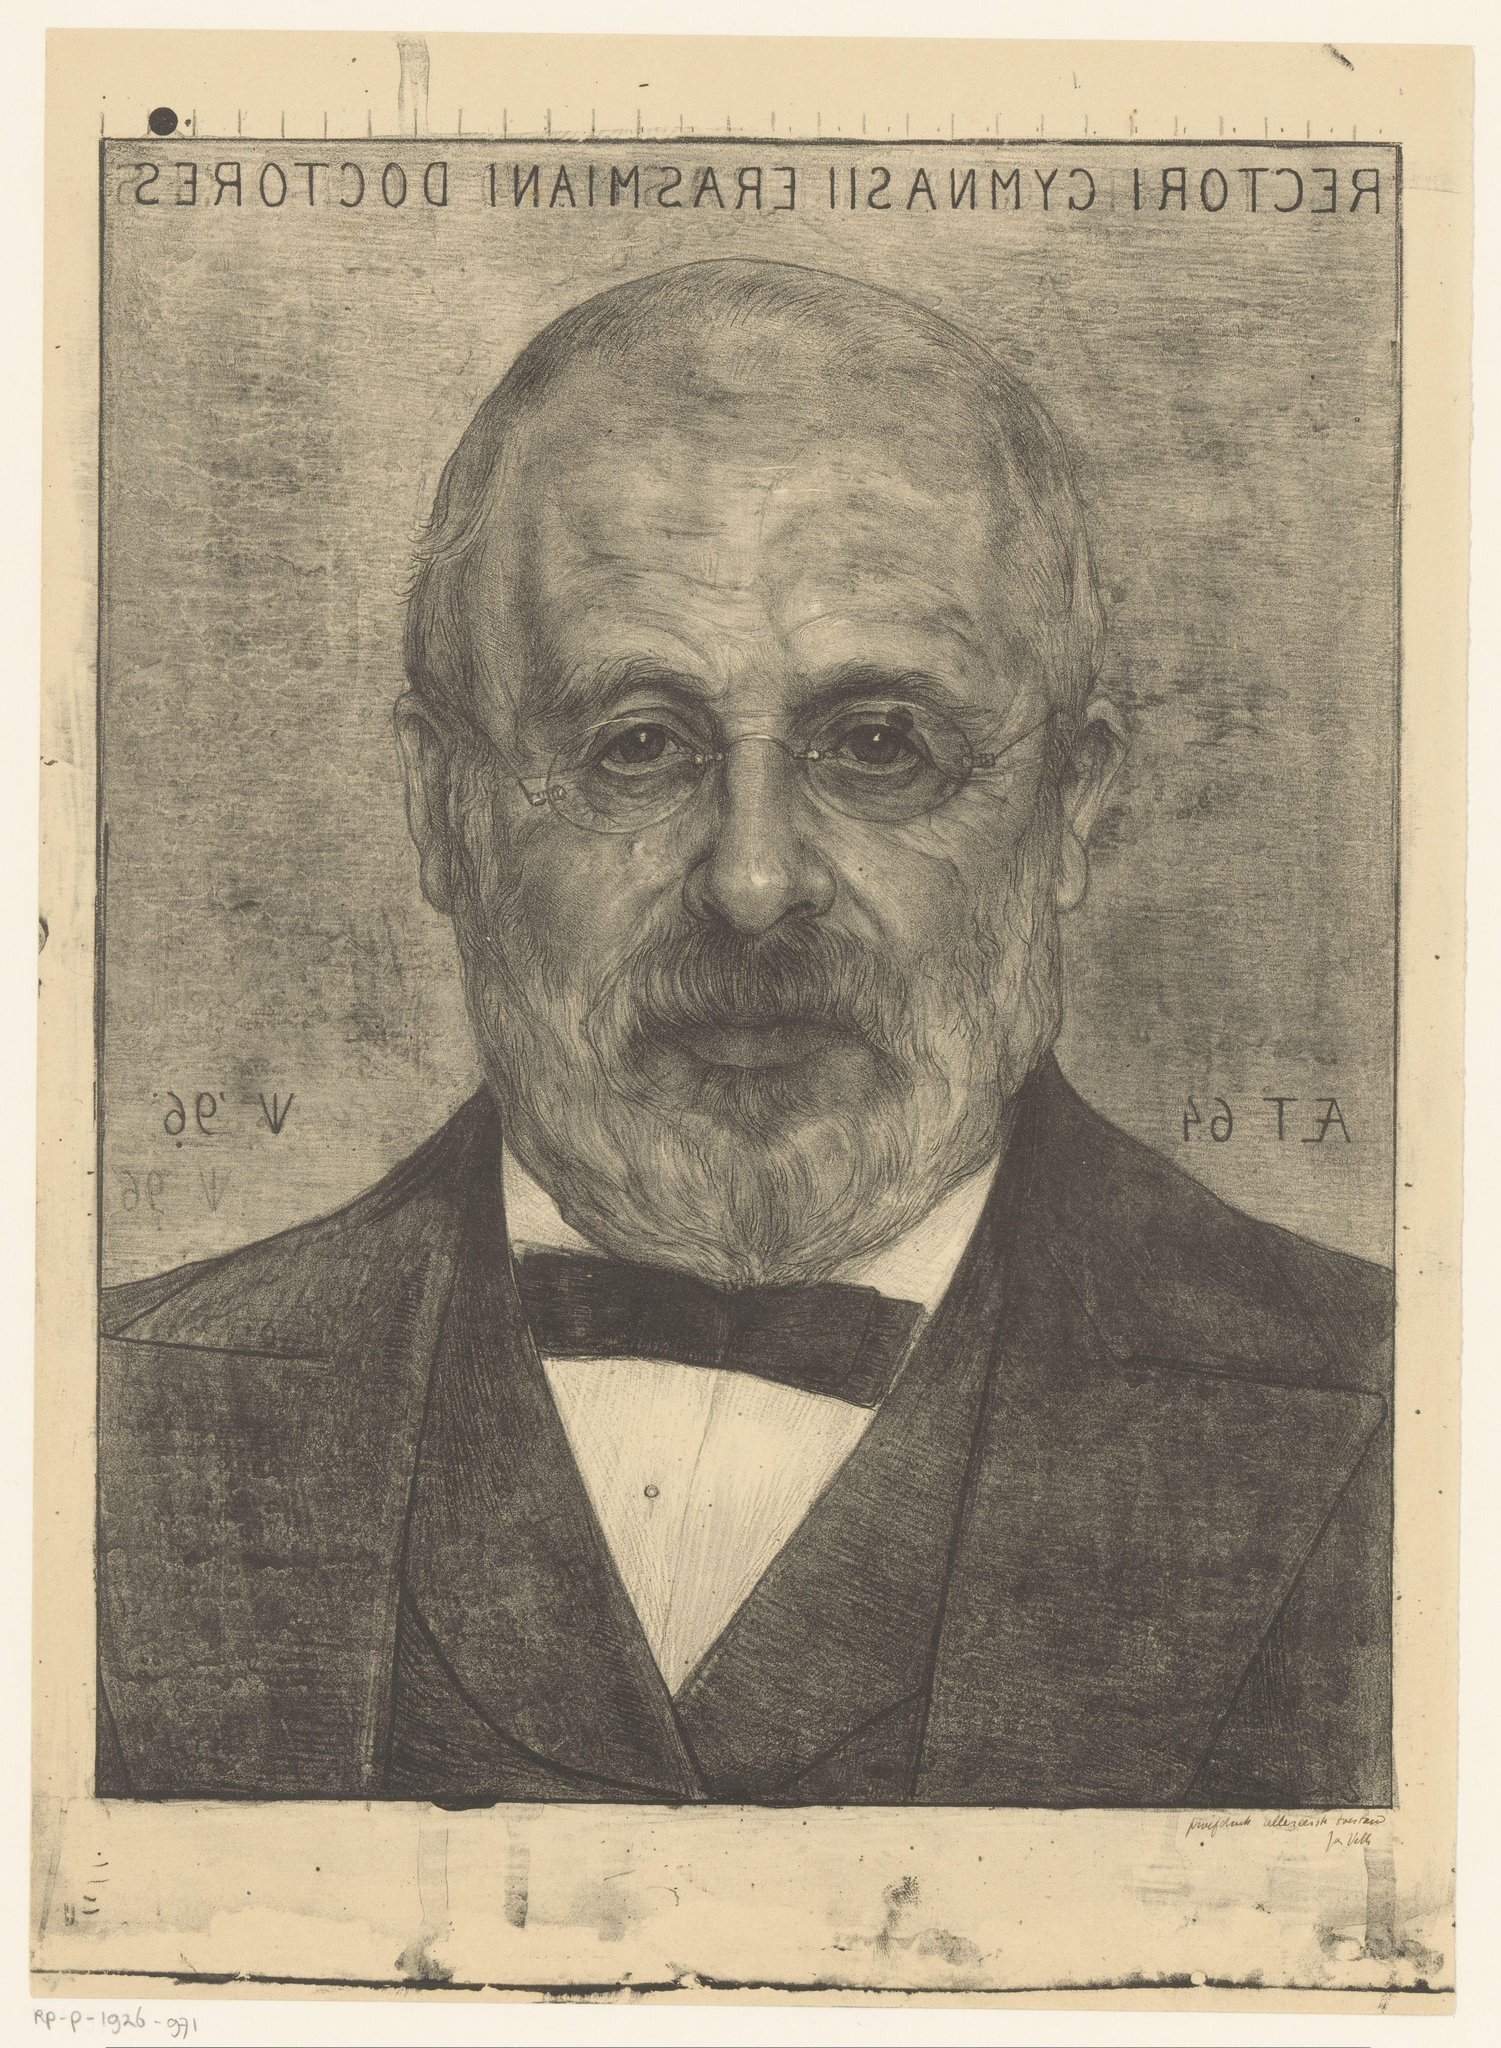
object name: print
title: Portret van Johannes Benedictus Kan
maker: jan veth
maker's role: designer, draughtsman, painter, print maker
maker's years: 1864-1925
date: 1896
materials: paper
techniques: lithograph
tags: historical persons (+ (full) bust portrait)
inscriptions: collector's mark: Lugt 2228, collector's mark: ‘H.G. Samson Amsterdam’, inscription: ‘proefdruk allereerste toestand / Jan Veth’